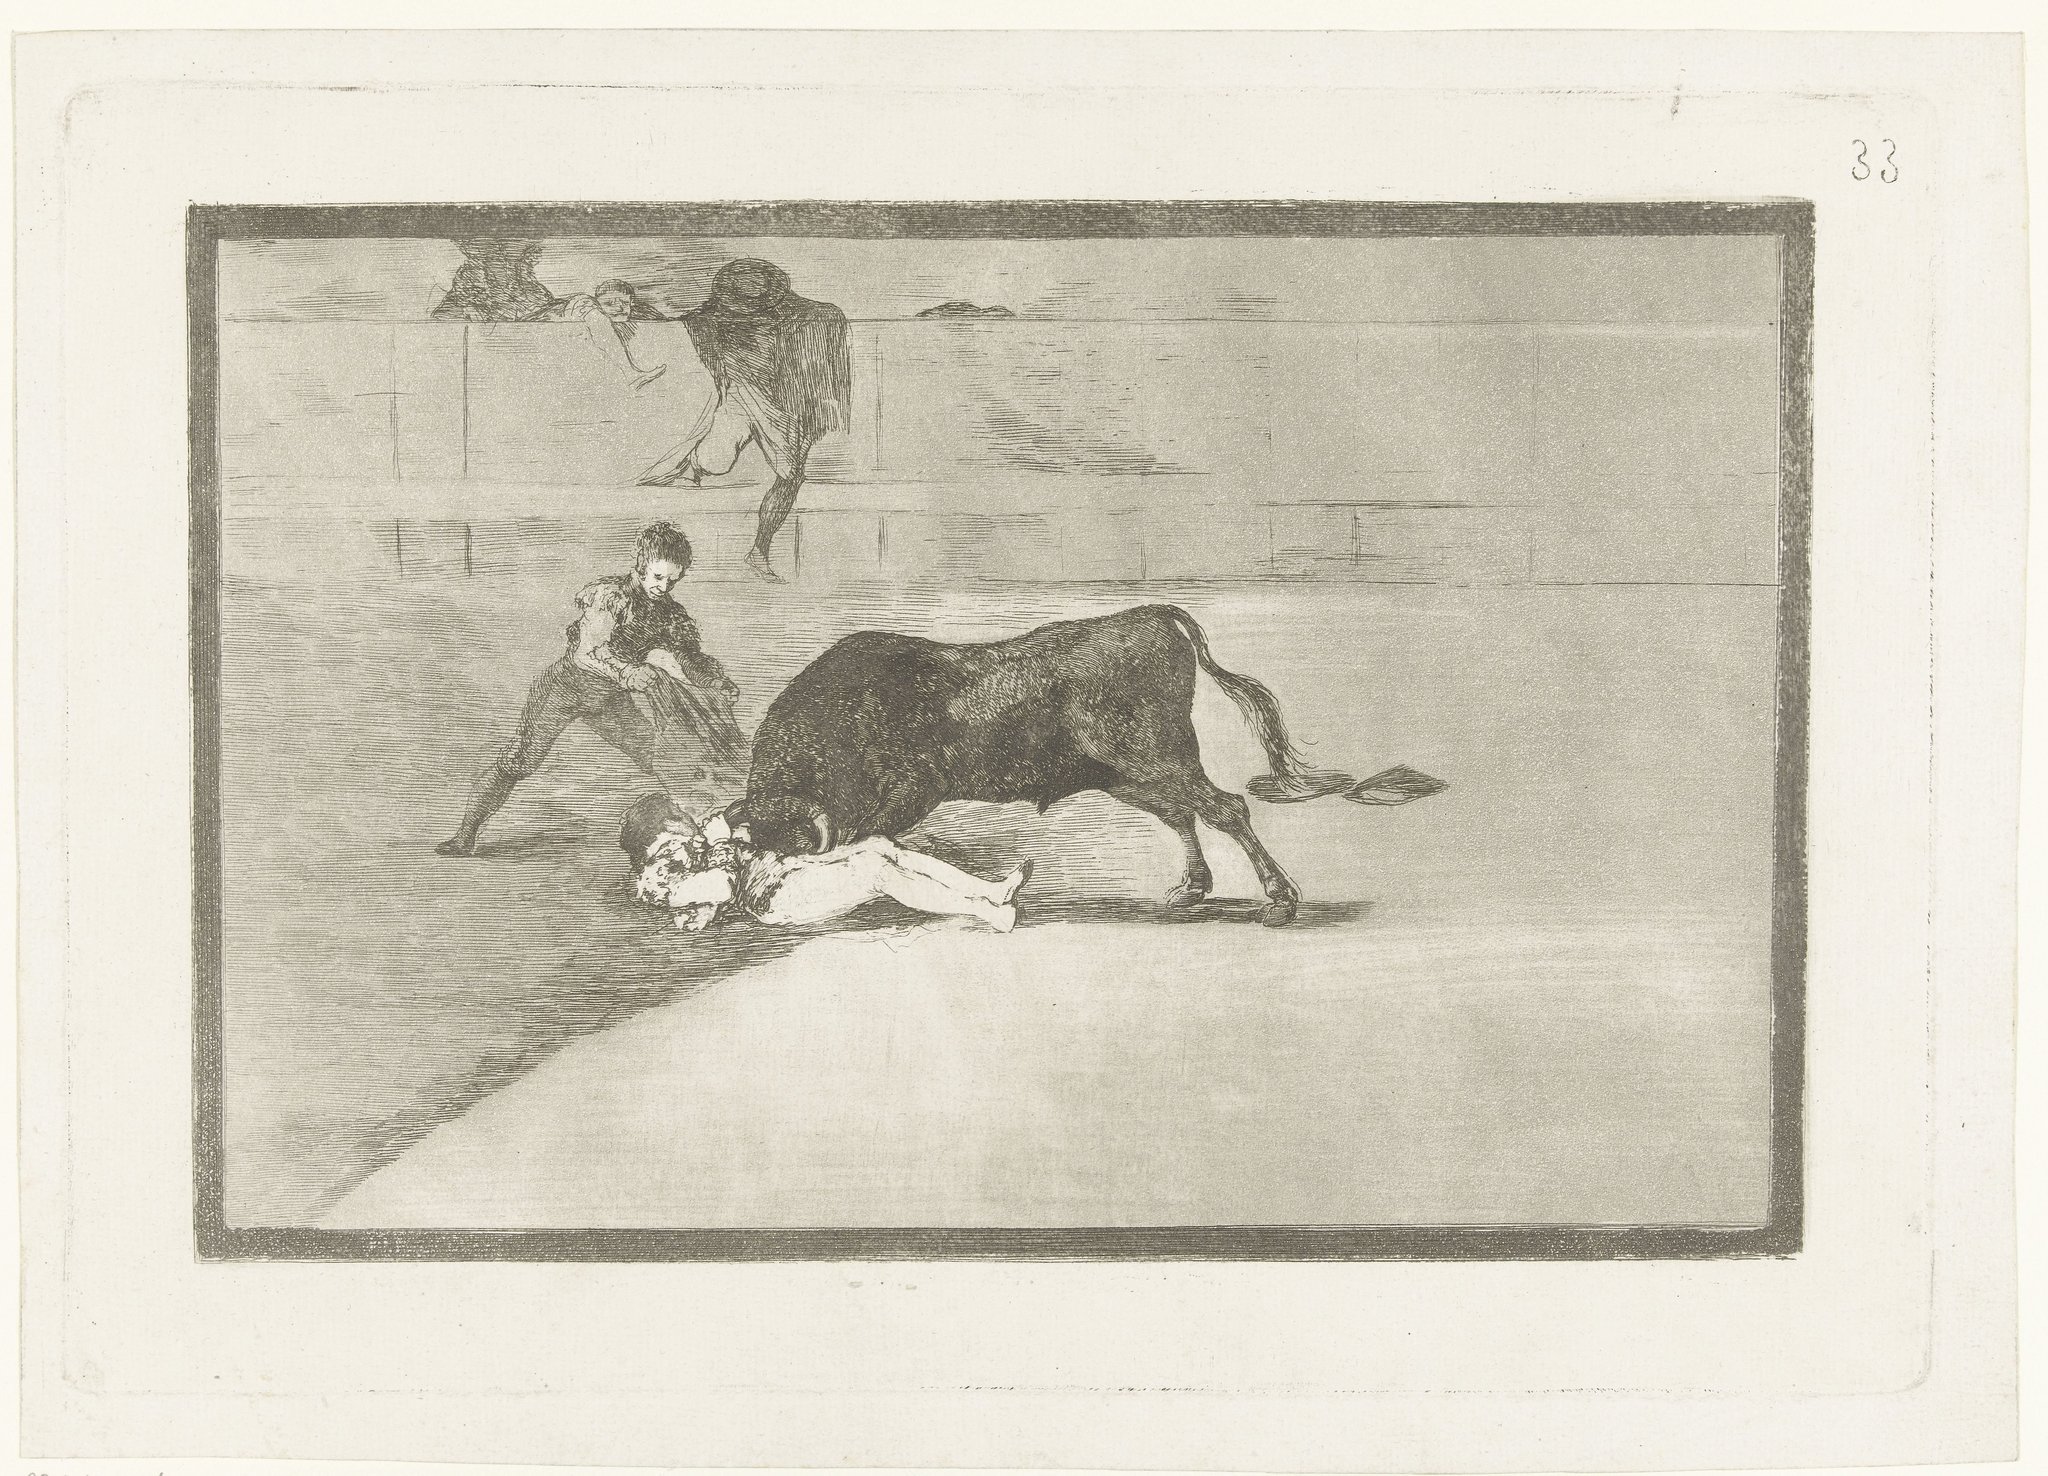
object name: print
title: La desgraciada muerte de Pepe Illo en la plaza de Madrid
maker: francisco de goya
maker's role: draughtsman, painter, print maker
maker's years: 1746-1828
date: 1811-1816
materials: paper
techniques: aquatint, drypoint, etching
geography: spain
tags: sevilla, bullfight, violent death, being killed; being mishandled and maltreated; seeking death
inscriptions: collector's mark: Lugt 805b, collector's mark: Lugt 2228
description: De torero (stierenvechter) Pepe-Hillo liggend op de grond in de arena van Madrid. Hij wordt gespietst aan de hoorns van de stier. Een andere man probeert de stier af te leiden met zijn cape.